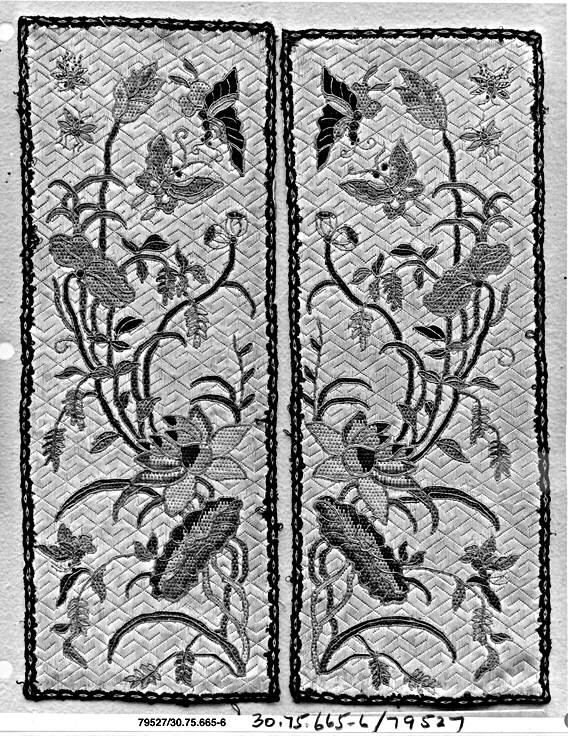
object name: panel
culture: chinese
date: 1644-1911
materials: metal thread, silk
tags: insects,butterflies,flowers